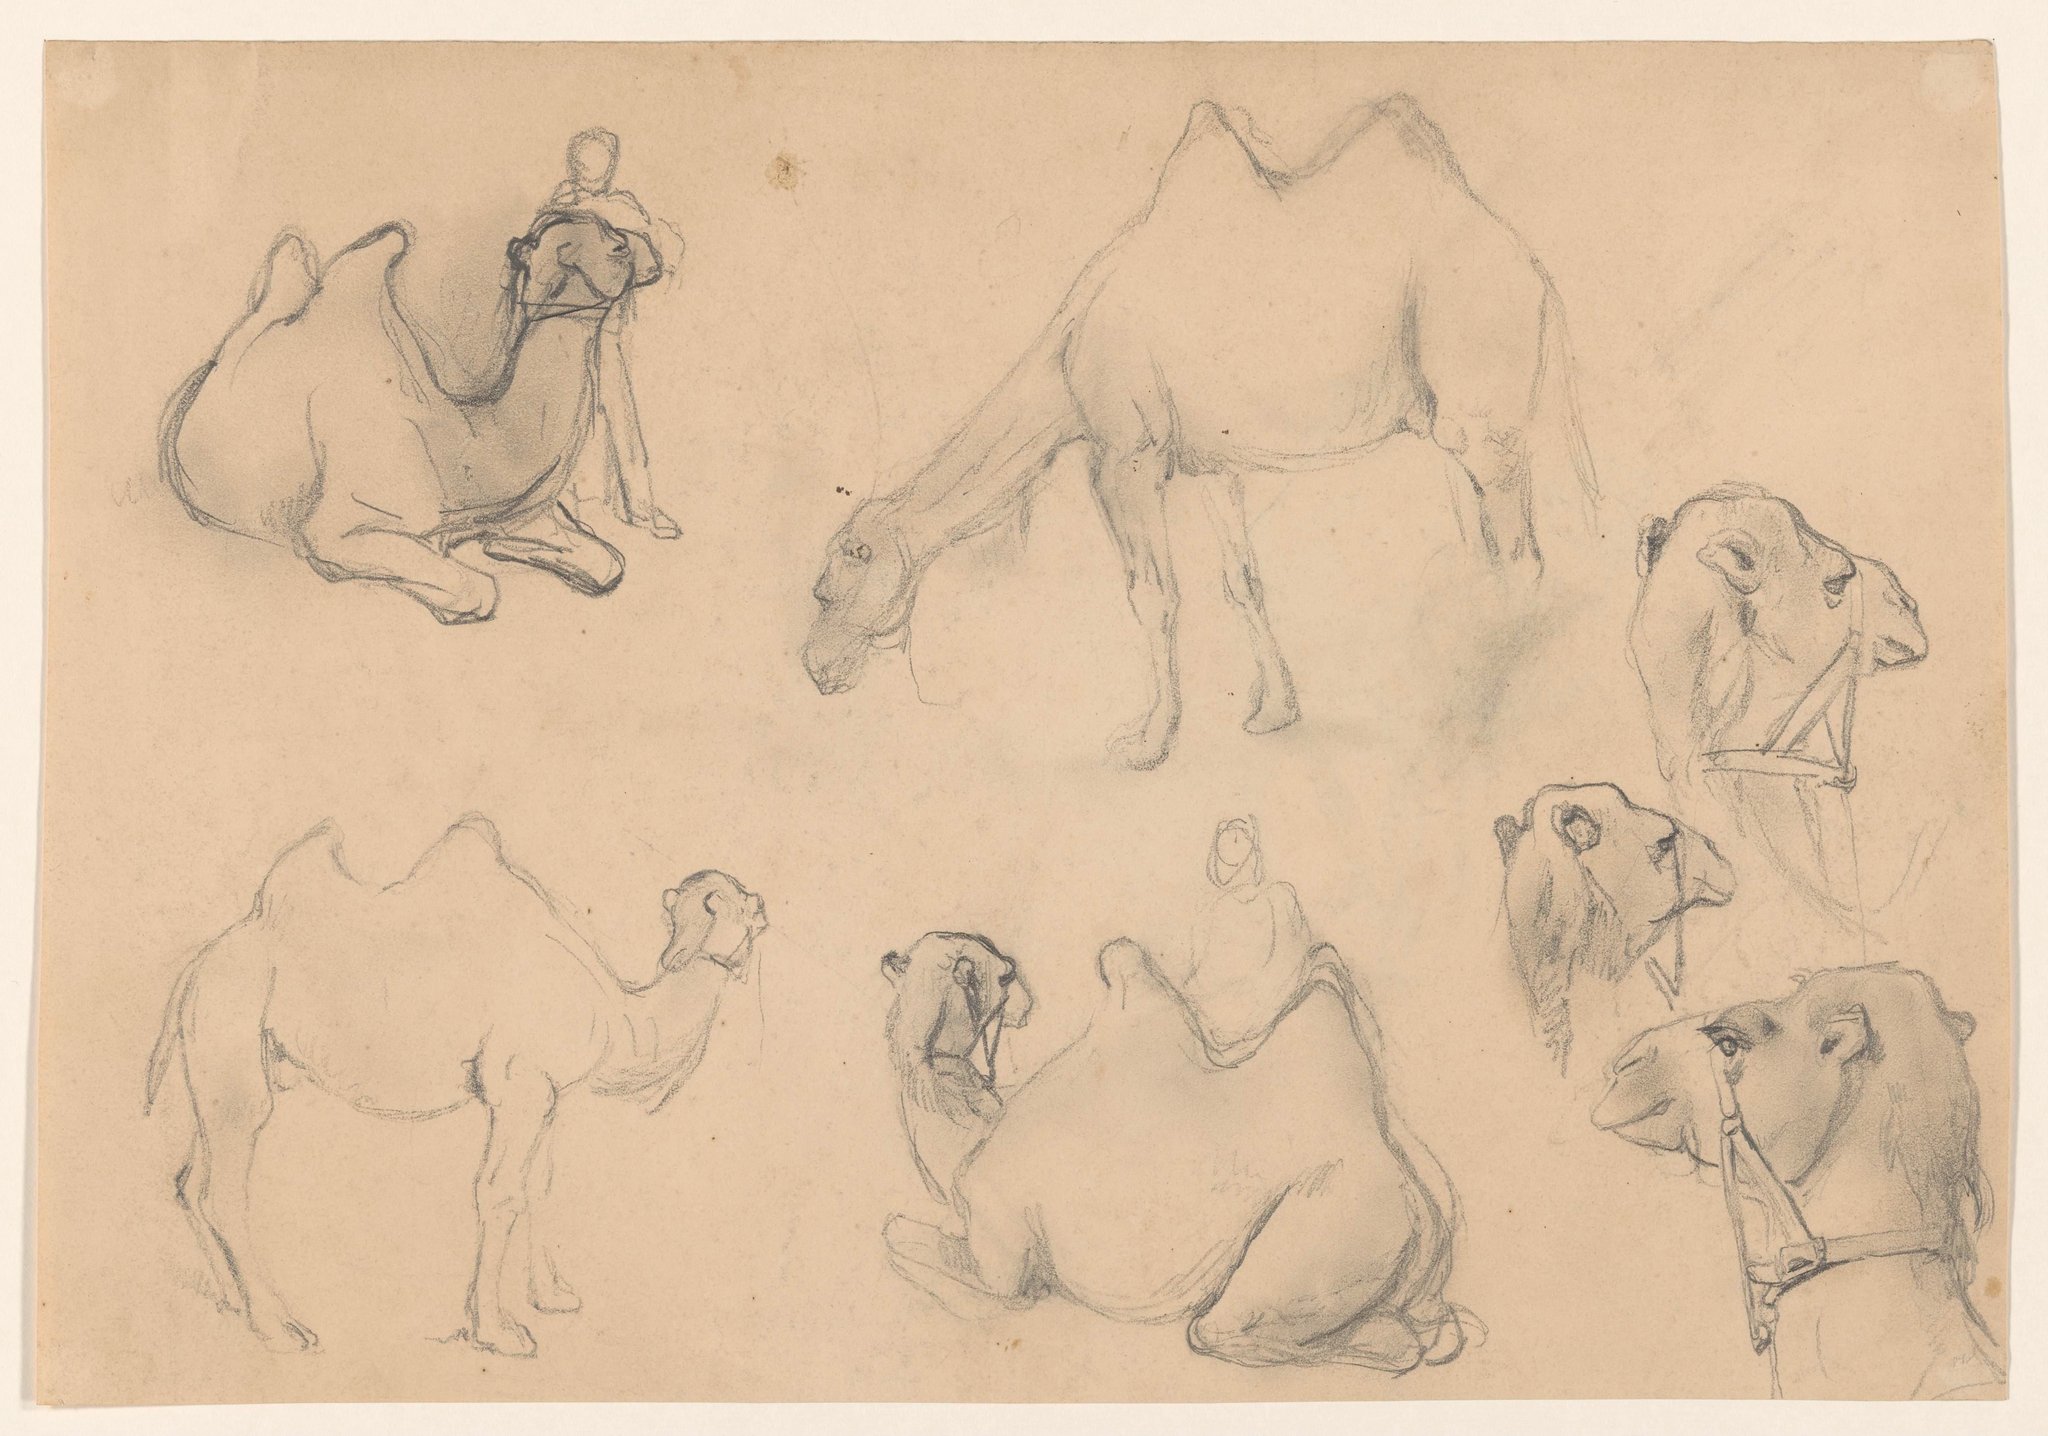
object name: drawing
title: Studies van kamelen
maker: cornelis kruseman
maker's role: draughtsman, painter, print maker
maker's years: 1797-1857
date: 1807-1857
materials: paper, pencil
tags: hoofed animals: camel